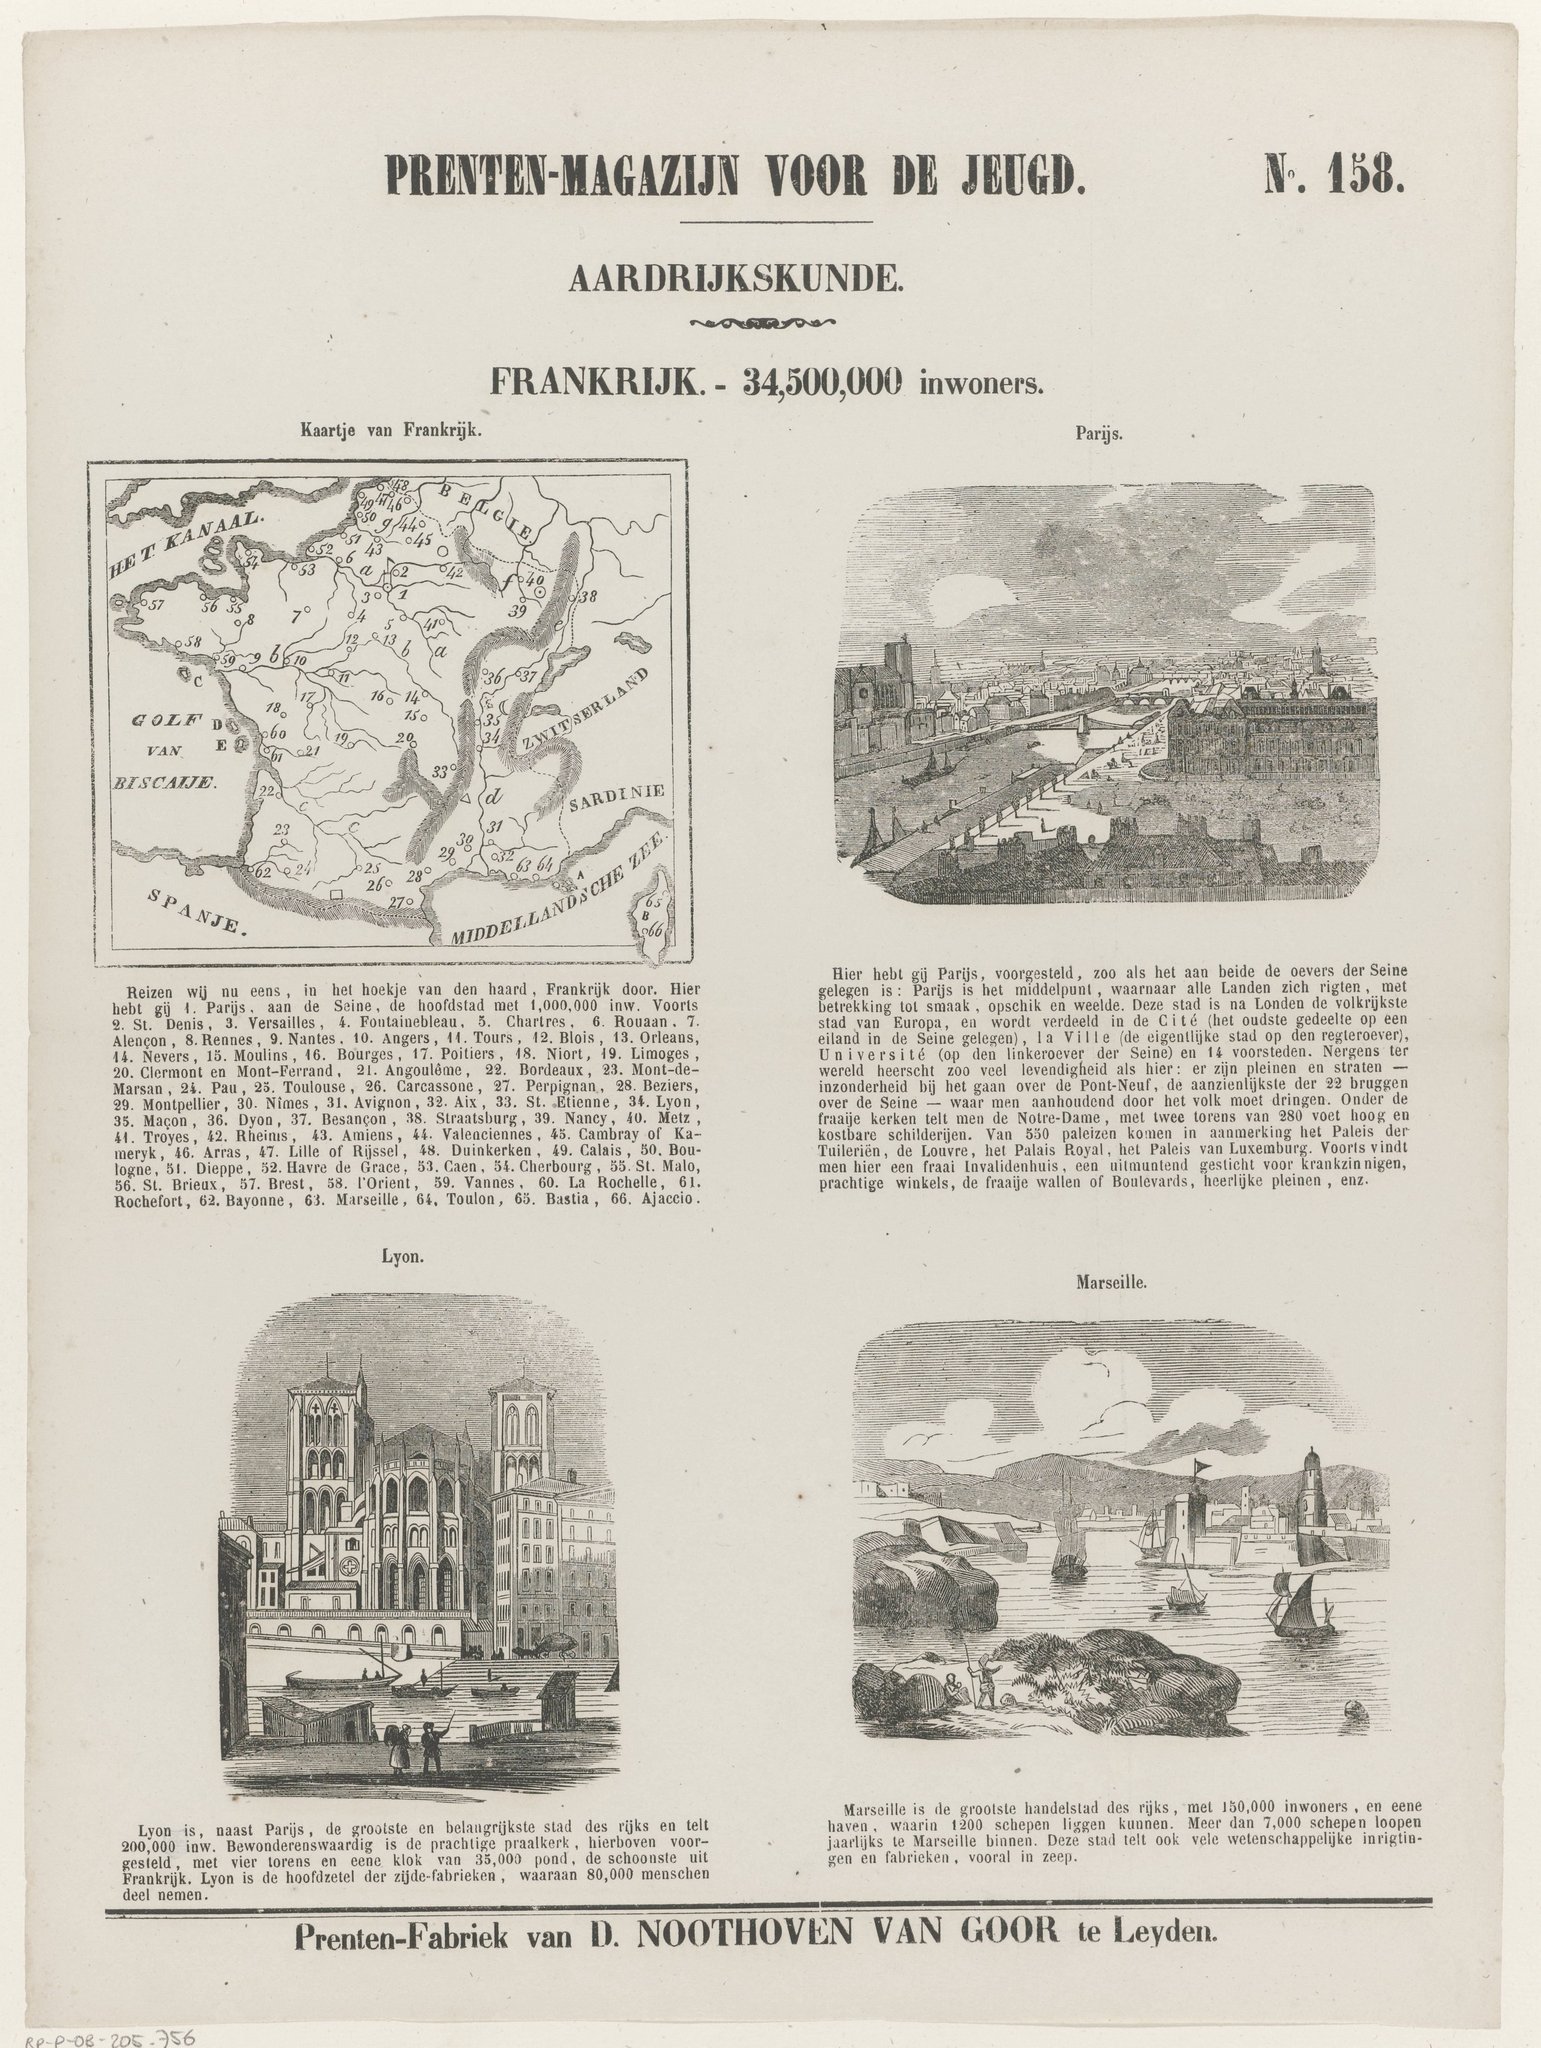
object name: print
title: Frankrijk. - 34,500,000 inwoners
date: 1850-1881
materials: paper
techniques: letterpress printing, engraving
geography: leiden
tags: maps, atlases, france, paris, marseille, lyon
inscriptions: collector's mark: Lugt 2760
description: Blad met 4 voorstellingen over Frankrijk met een kaart en belangrijke steden: Parijs, Lyon en Marseille. Boven elke voorstelling een titel en onder elke voorstelling een onderschrift. Genummerd rechtsboven: No. 158.